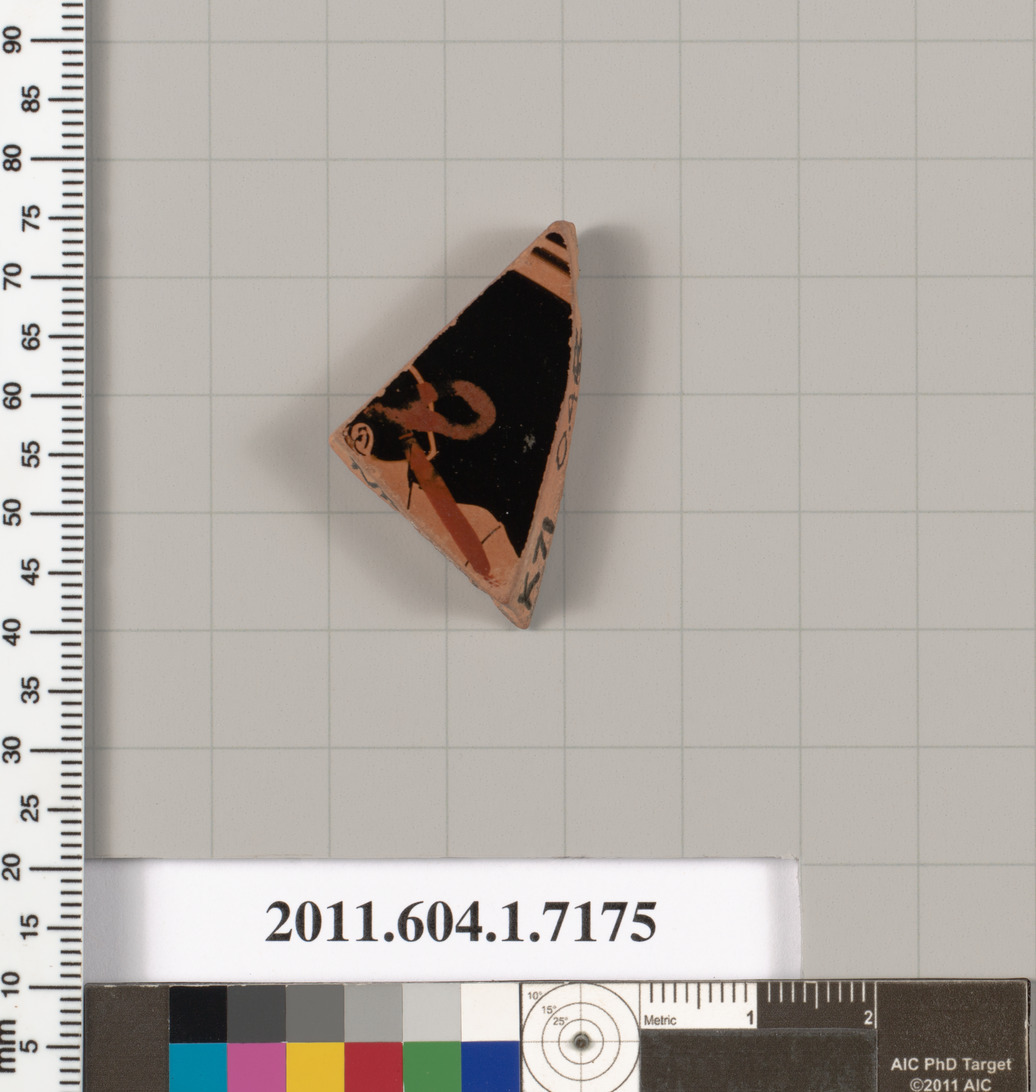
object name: kylix fragment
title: Terracotta fragment of a kylix (drinking cup)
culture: greek, attic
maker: makron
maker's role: artist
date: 500-480 BCE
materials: terracotta